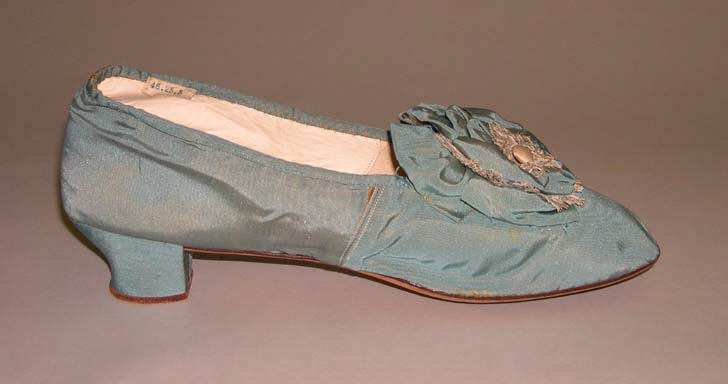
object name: slipper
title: Slippers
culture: french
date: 1870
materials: leather, silk